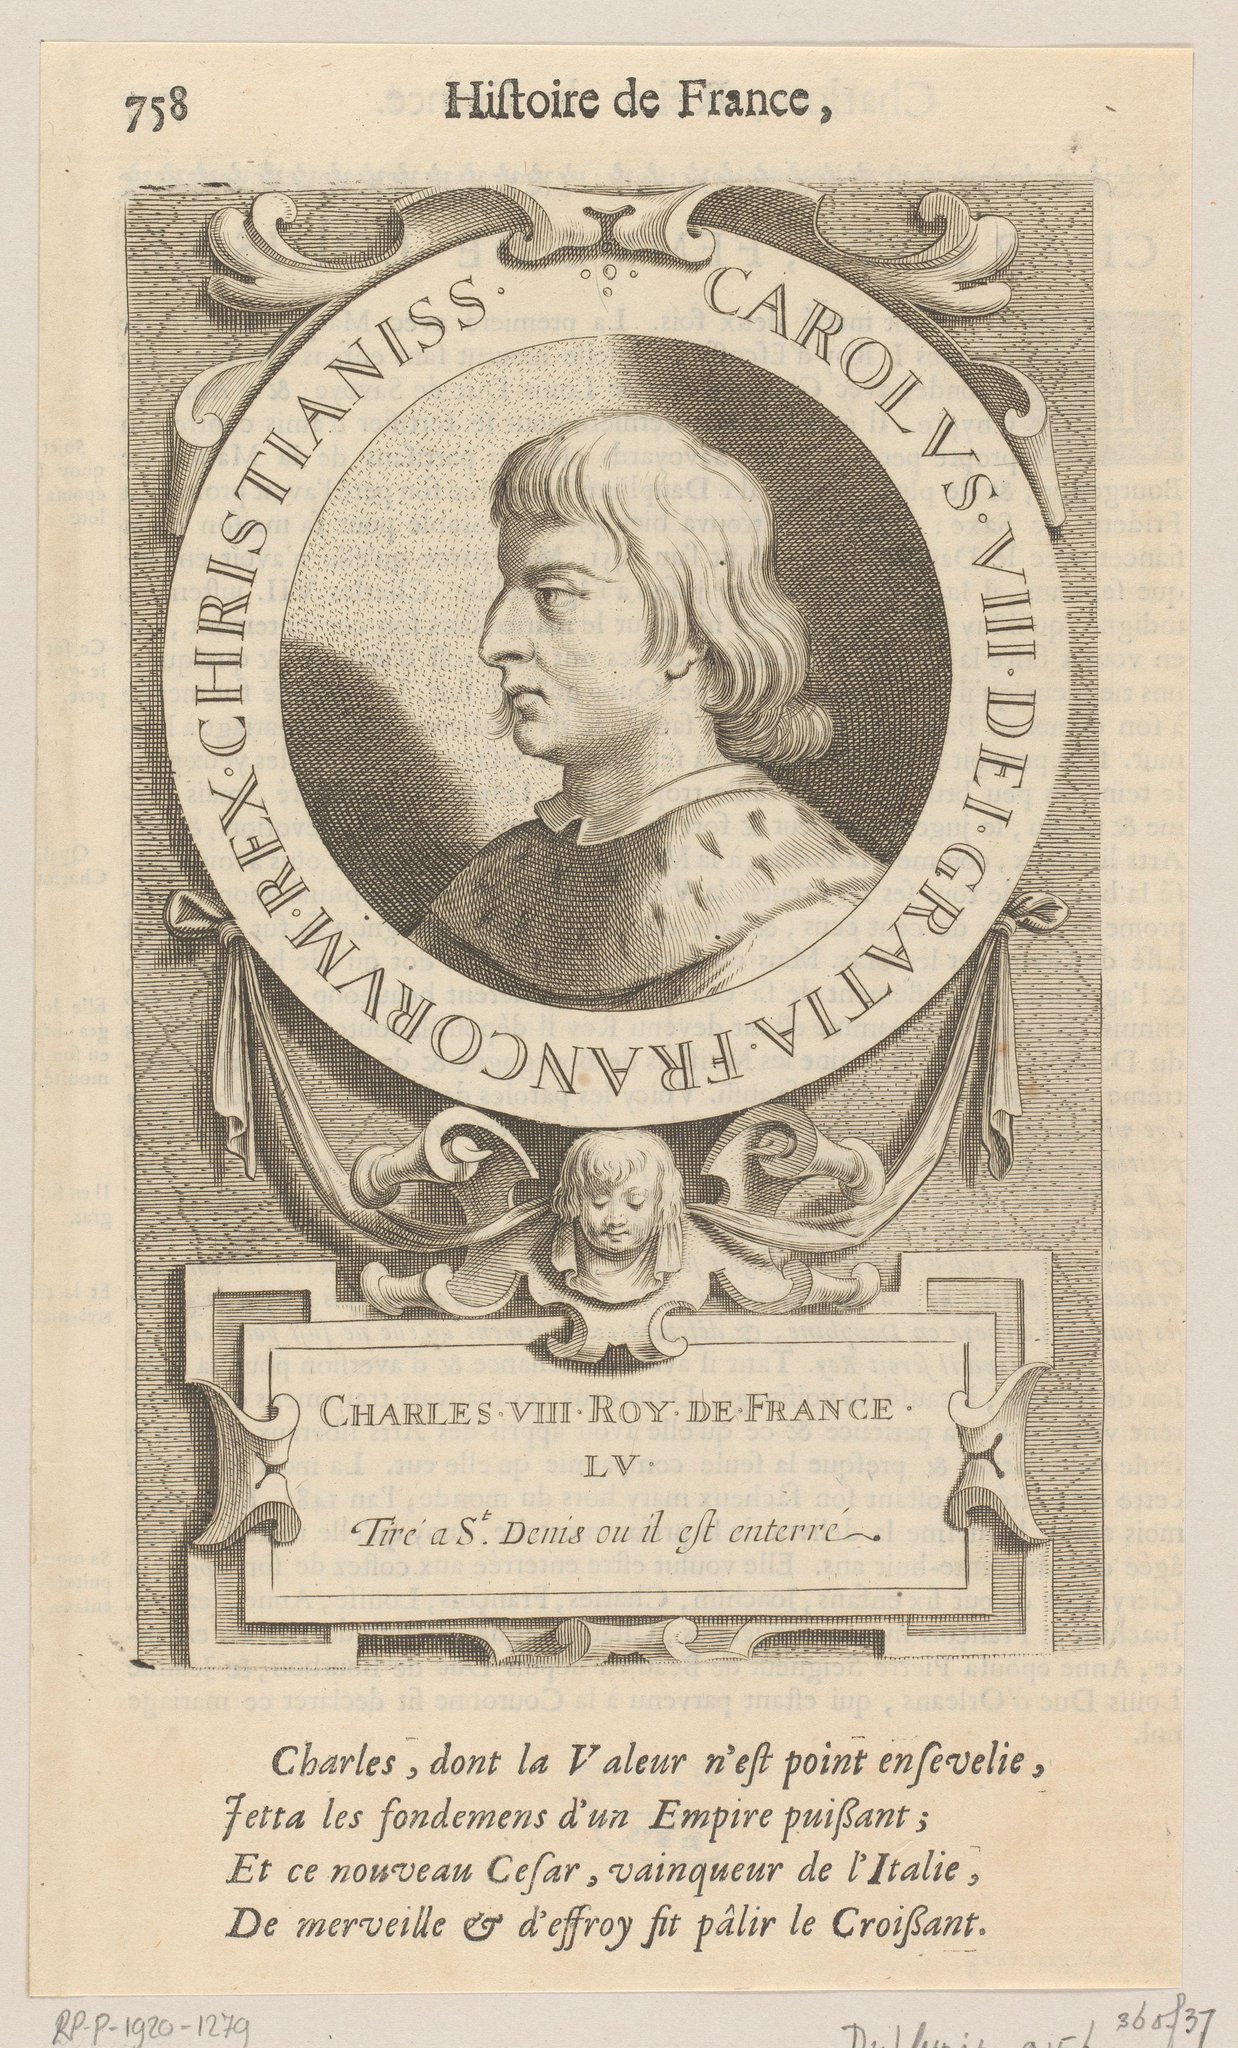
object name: print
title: Charles VIII roy de France LV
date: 1635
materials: paper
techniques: engraving, letterpress printing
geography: paris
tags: historical persons, ruler, sovereign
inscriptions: collector's mark: Lugt 2228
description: Prent uit: Eudes de Mézeray, François. Histoire de France, depuis Faramond jusqu’au regne de Louis le Juste (...). 3 dln. Parijs: Denis Thierry, Jean Guignard en Claude Barbin, 1635, dl. 2. Prent waarschijnlijk voor het eerst verschenen in: Bie, Jacques de. Les vrais portraits des rois de France (...). Parijs: Jacques de Bie en Pierre Rocolet, 1634. Prent ook gebruikt in latere publicaties.